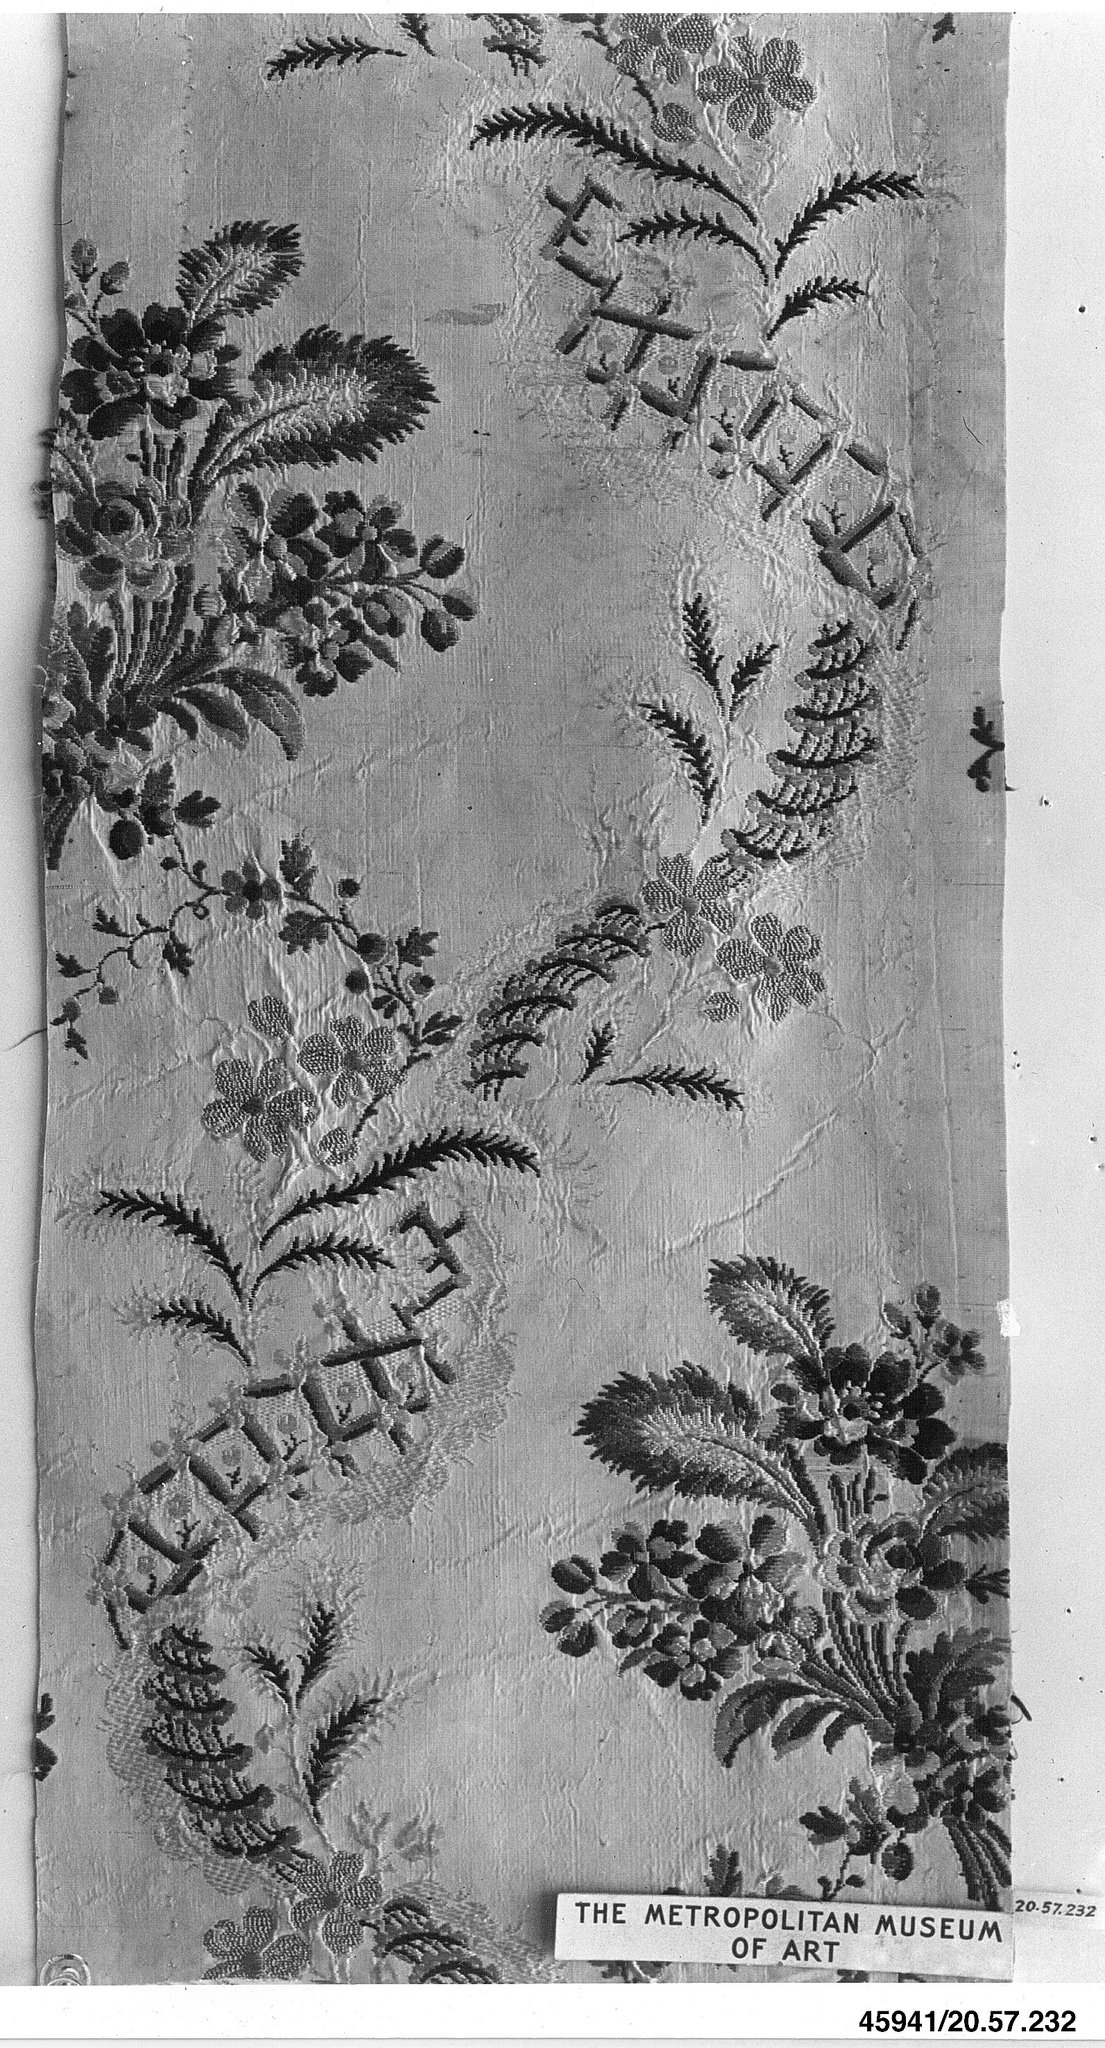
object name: piece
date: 1750-1760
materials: silk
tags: flowers,leaves